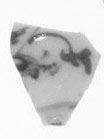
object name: shard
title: Shard (Study Collection)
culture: chinese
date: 1368-1911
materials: porcelain